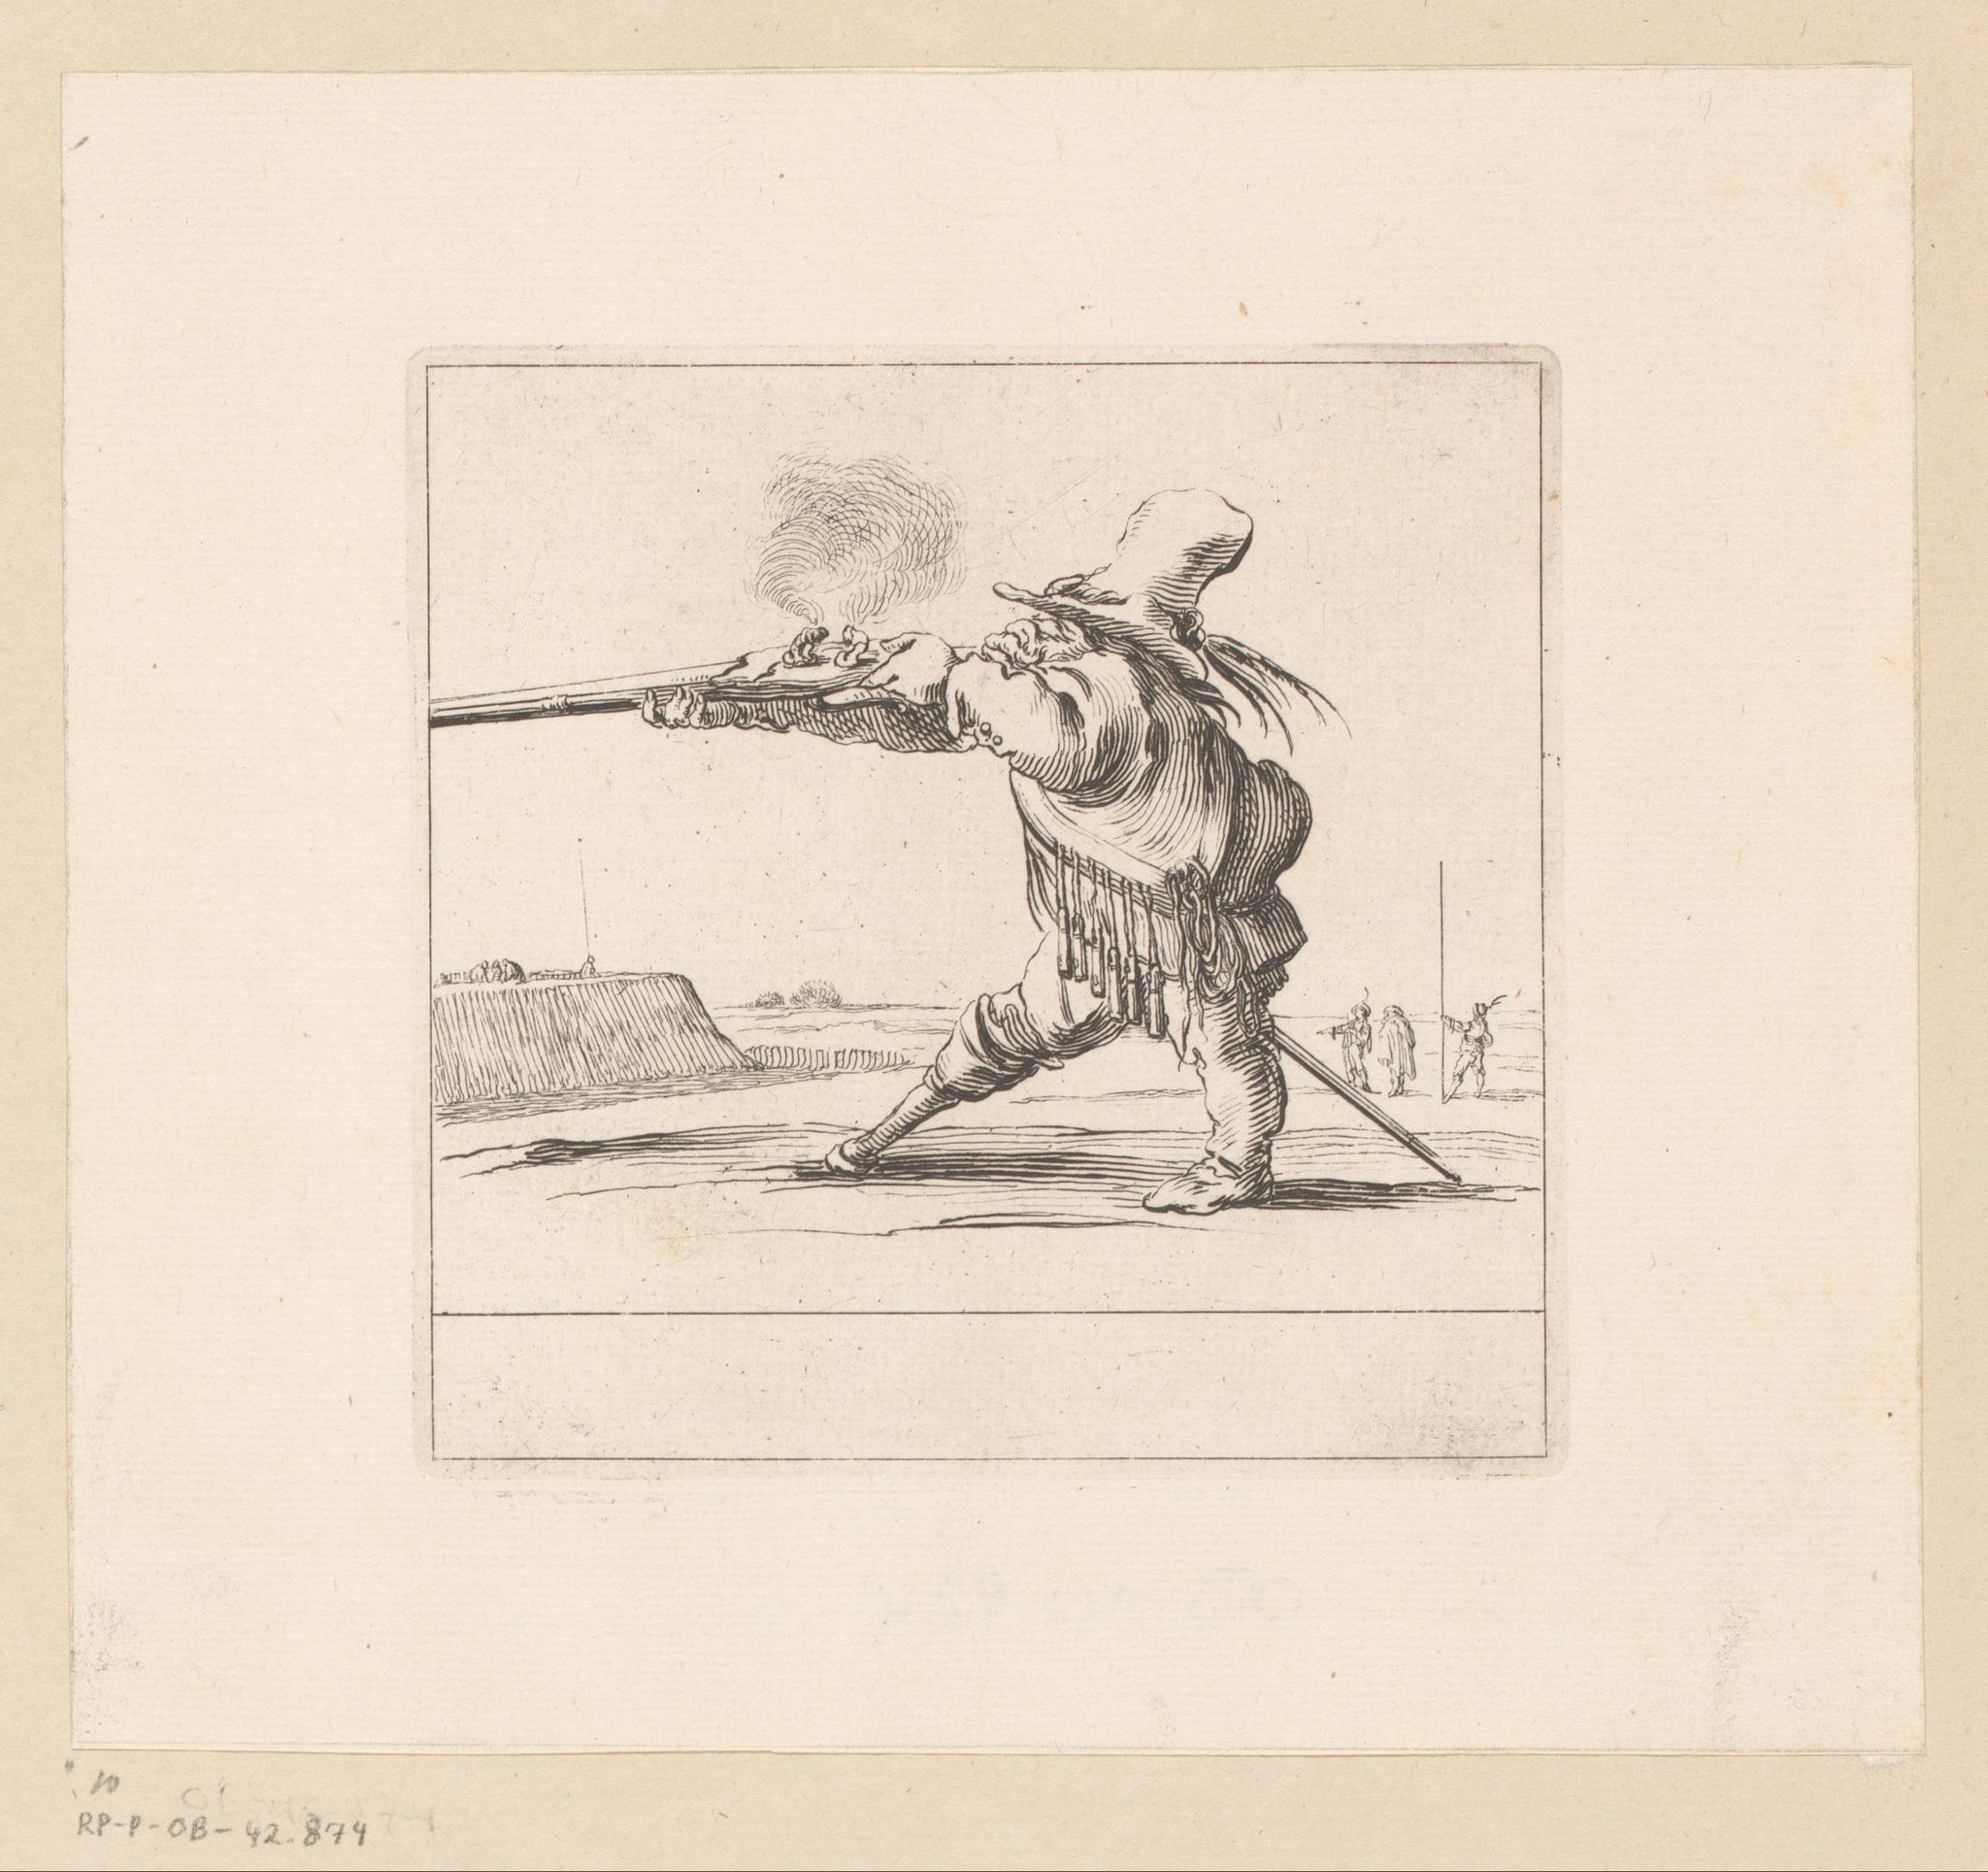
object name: print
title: Karikatuur van een schietende man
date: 1620-1687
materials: paper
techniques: etching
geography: france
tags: caricatures (human types), adult man, firearms: rifle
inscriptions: collector's mark: Lugt 240